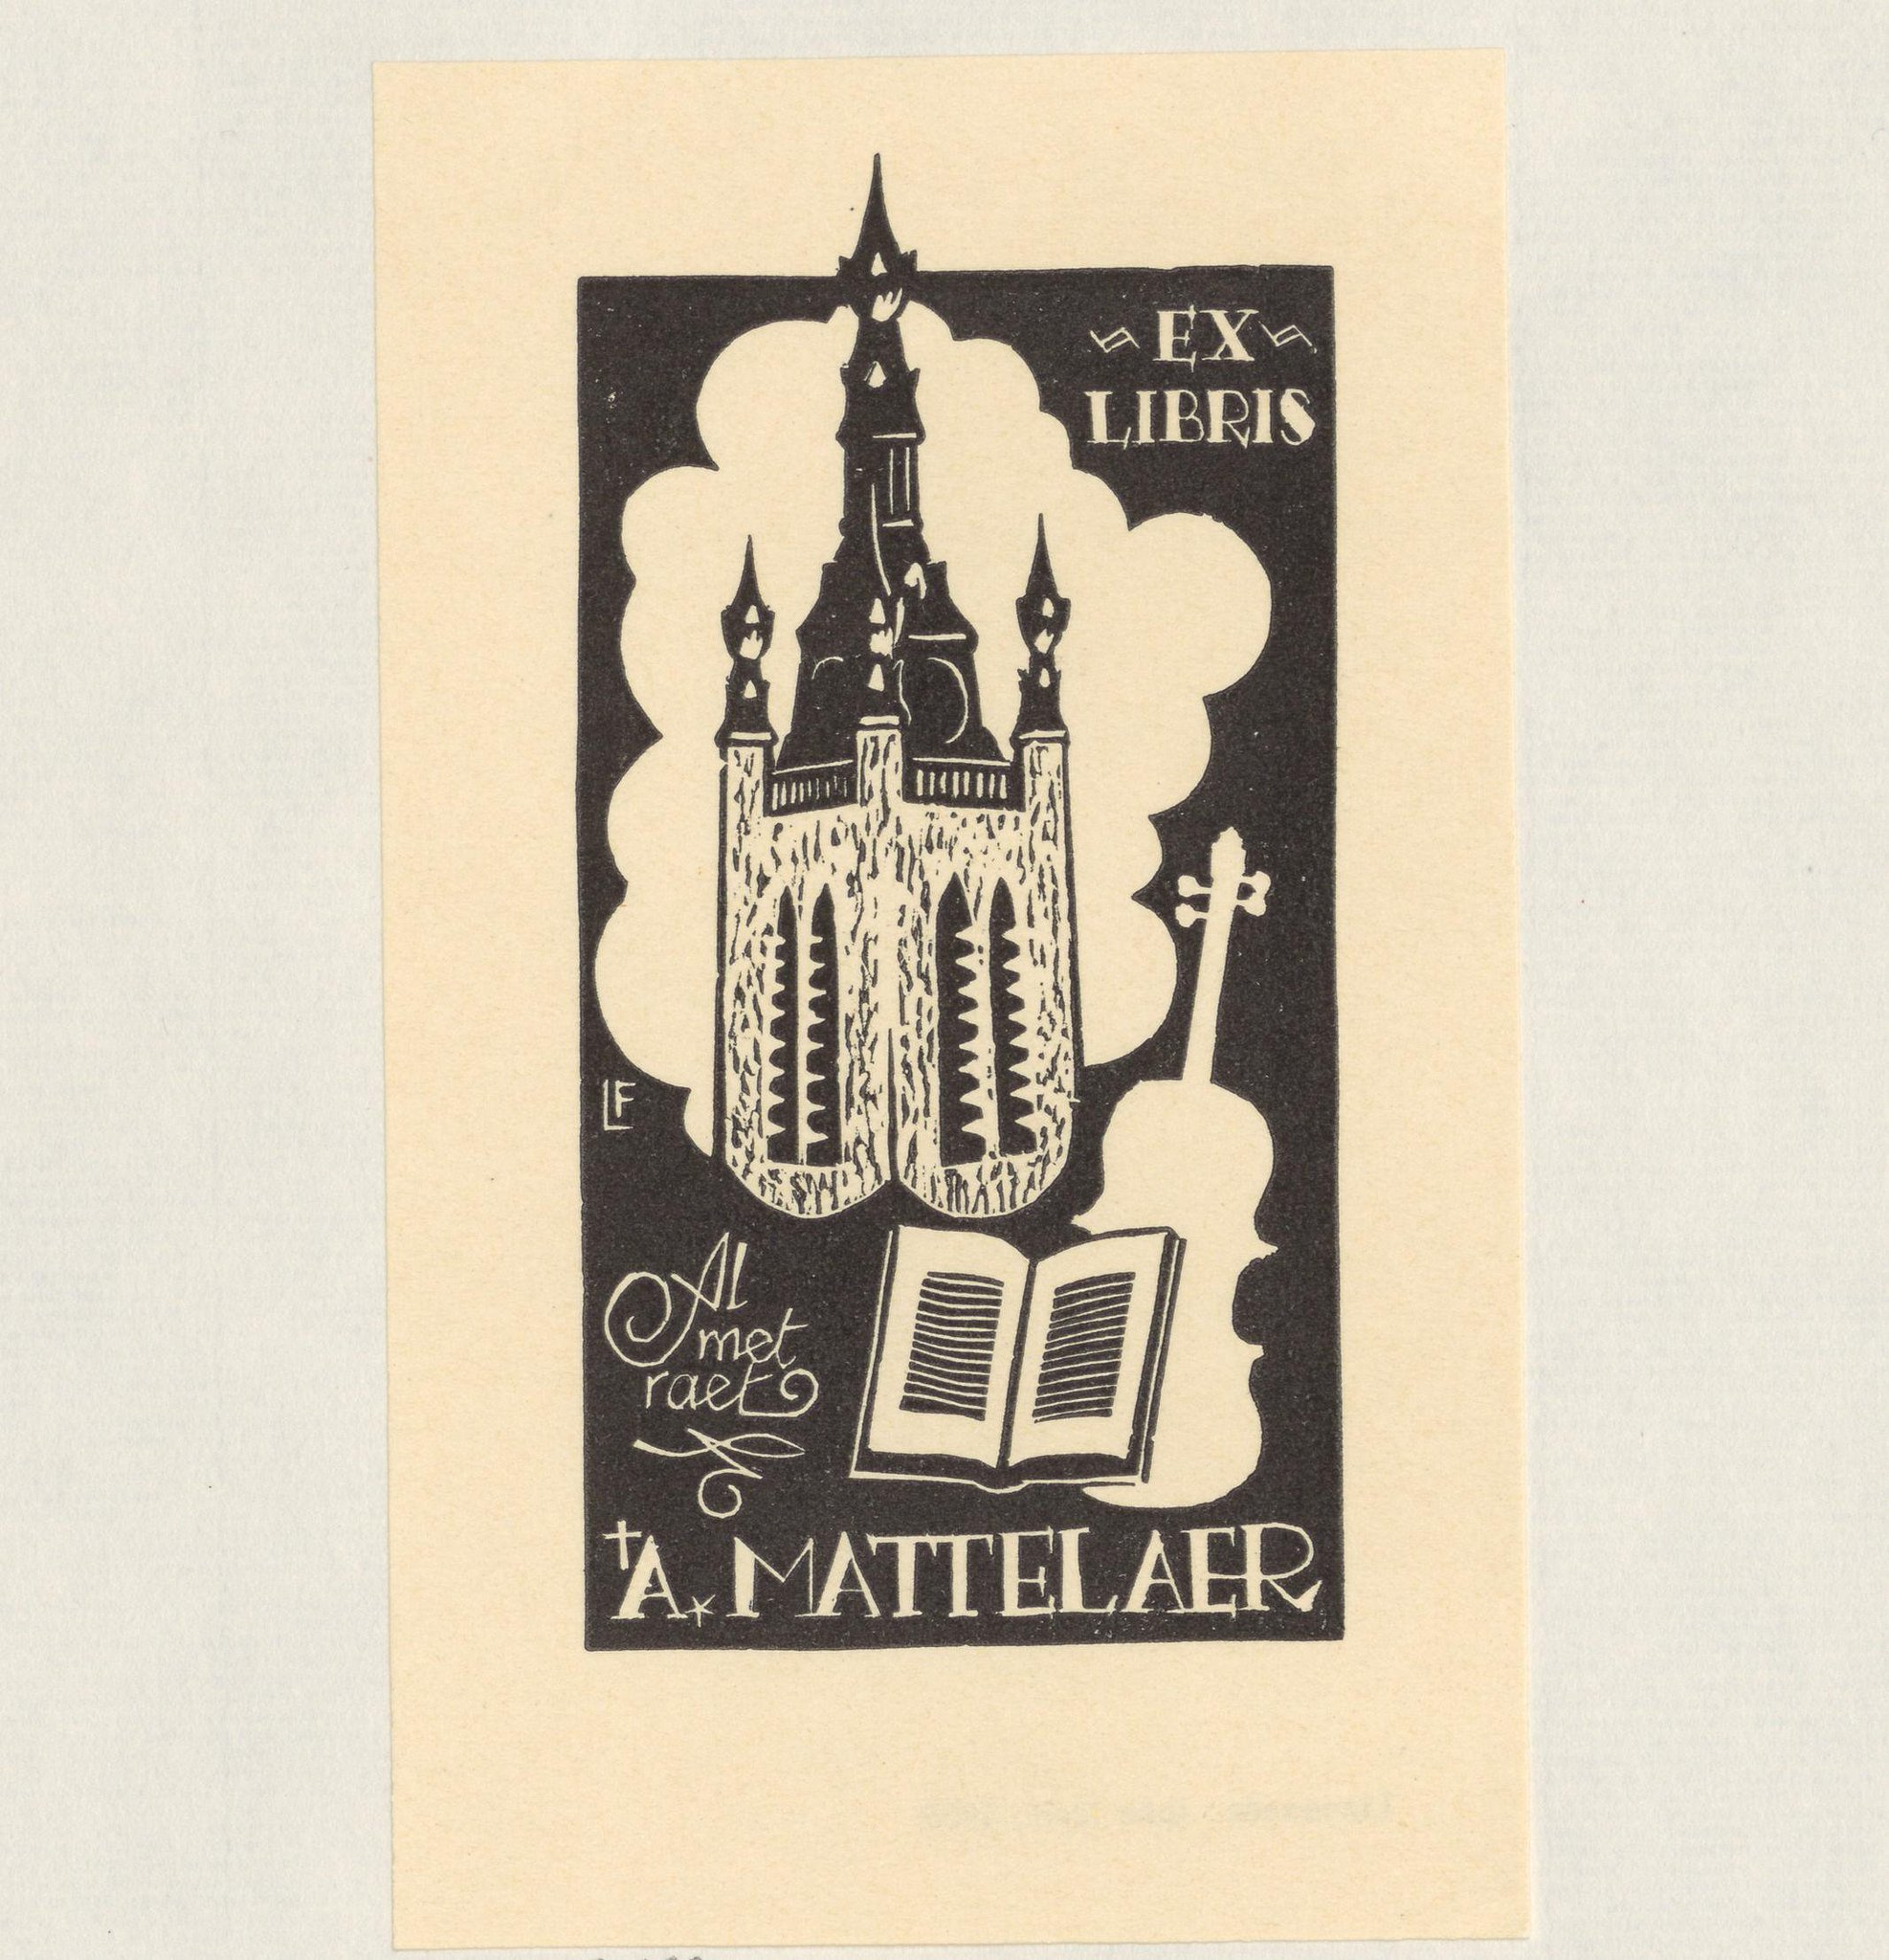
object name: bookplate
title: Ex libris van A. Mattelaer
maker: frans lasure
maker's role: print maker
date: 1955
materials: paper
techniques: linocut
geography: netherlands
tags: parts of church exterior and annexes: campanile, violin, fiddle, book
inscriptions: inscription: ‘Linosnede: ipse fecit; 1955.’